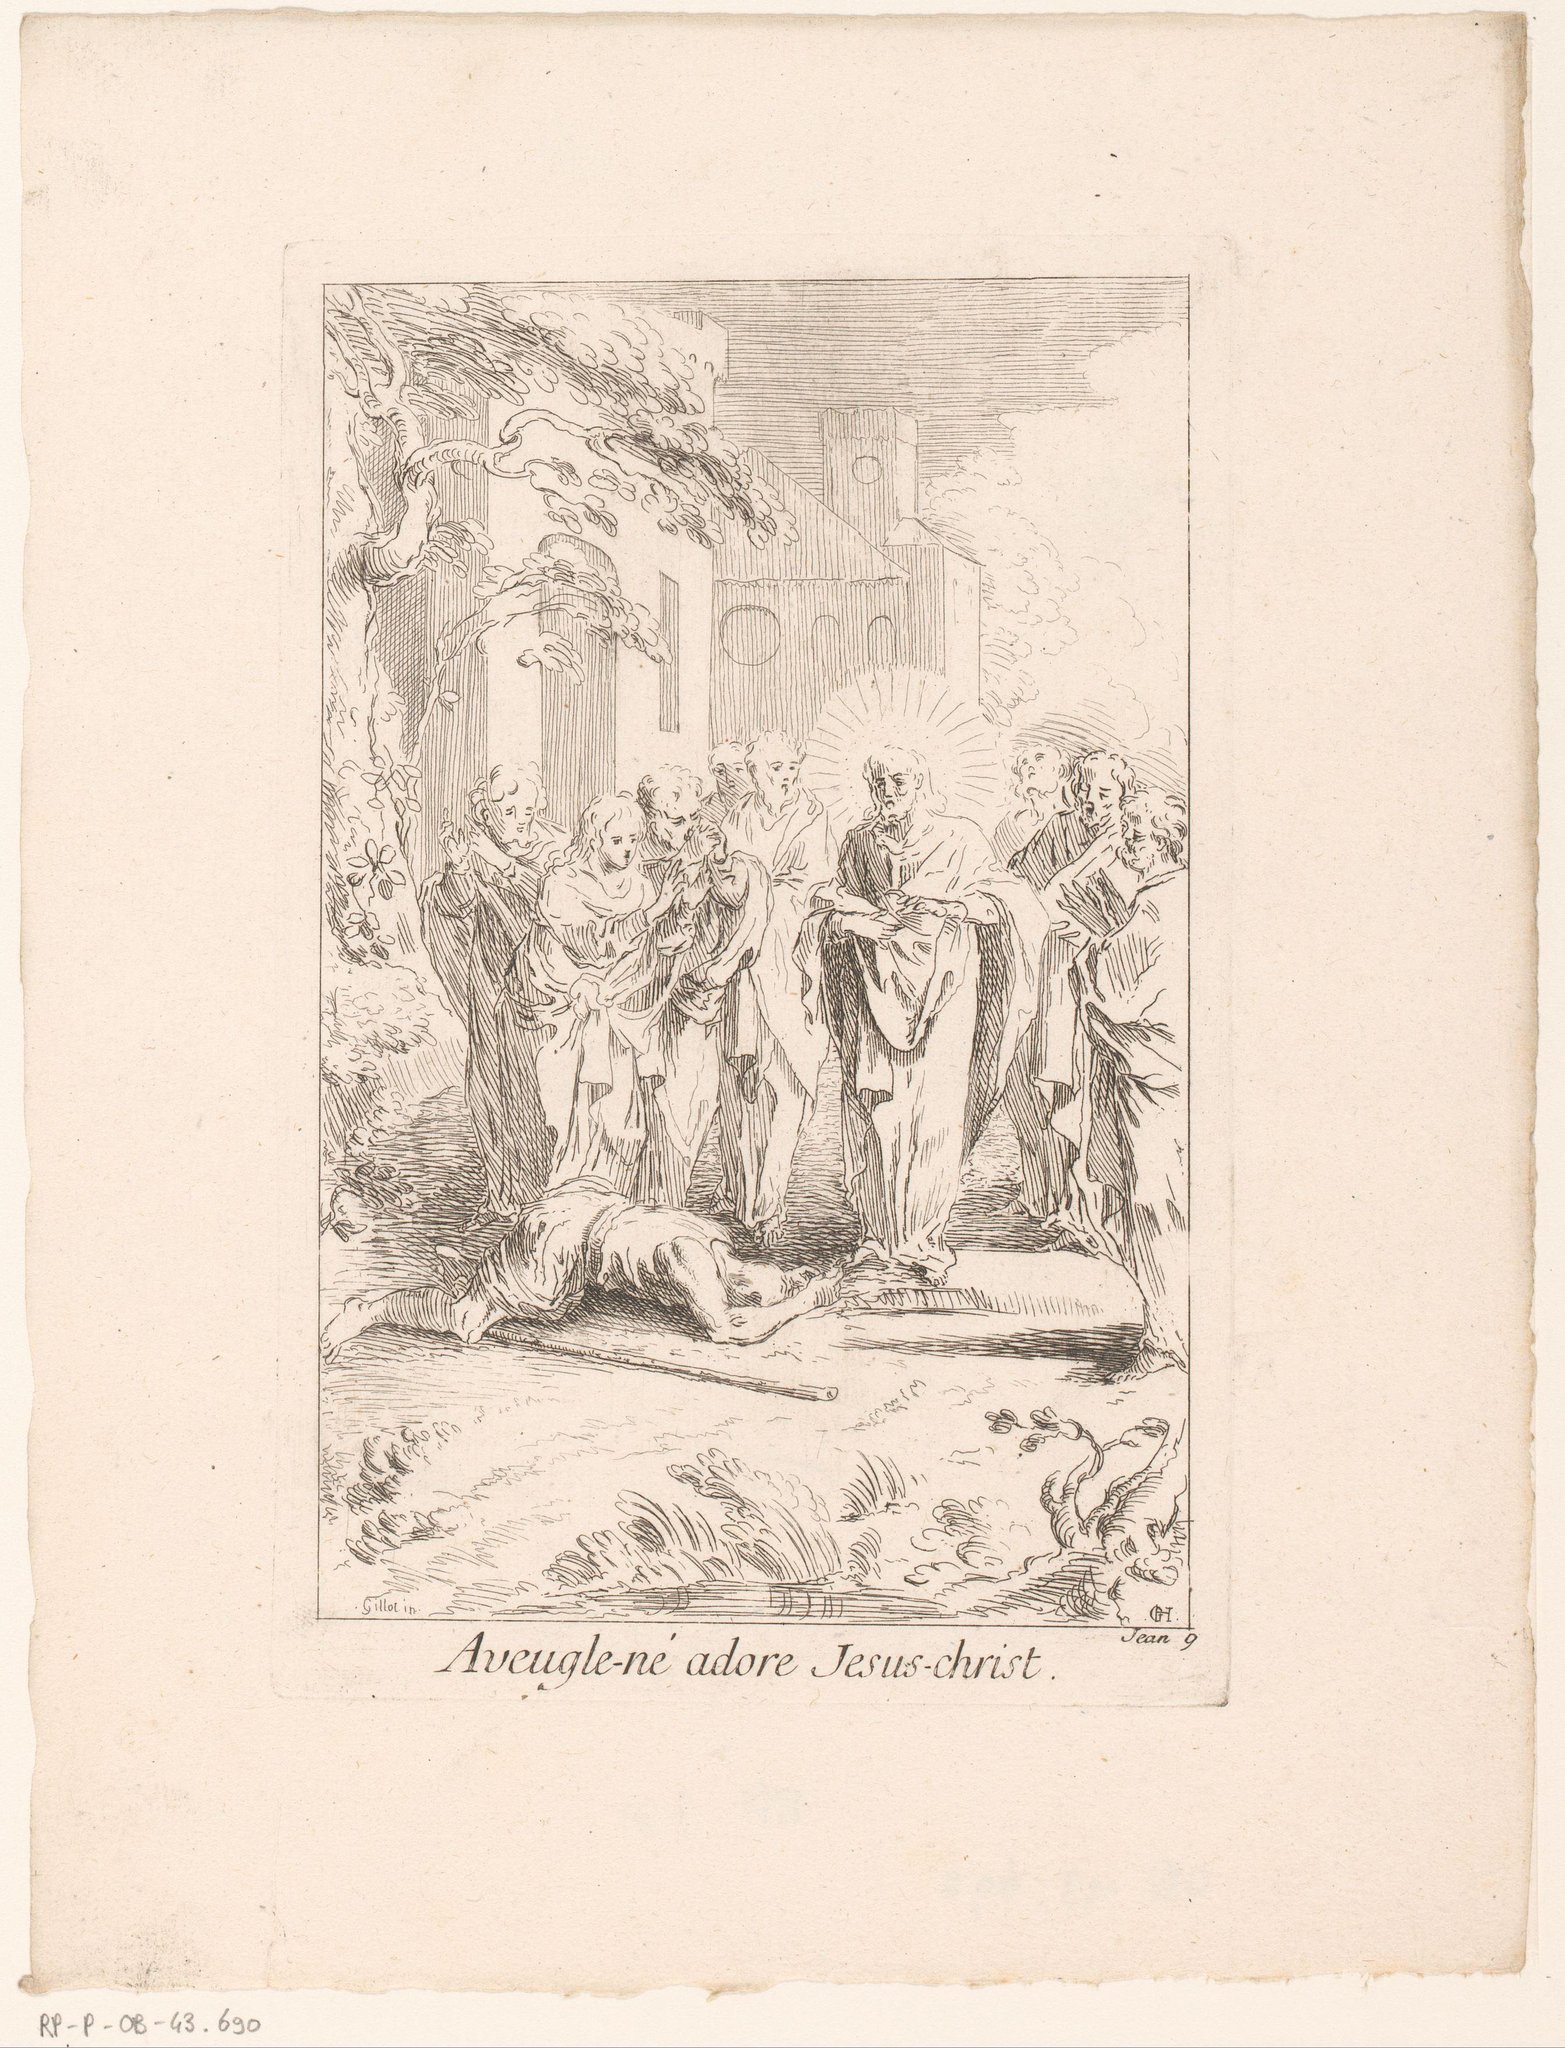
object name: print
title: Blindgeborene aanbidt Christus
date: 1705-1732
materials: paper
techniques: etching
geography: france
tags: healing of a man born blind: christ touches his eyes with an 'ointment' of dust and spittle (john 9)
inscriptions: collector's mark: Lugt 2228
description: Maakt deel uit van een serie met zestig prenten met als thema het leven van Christus.